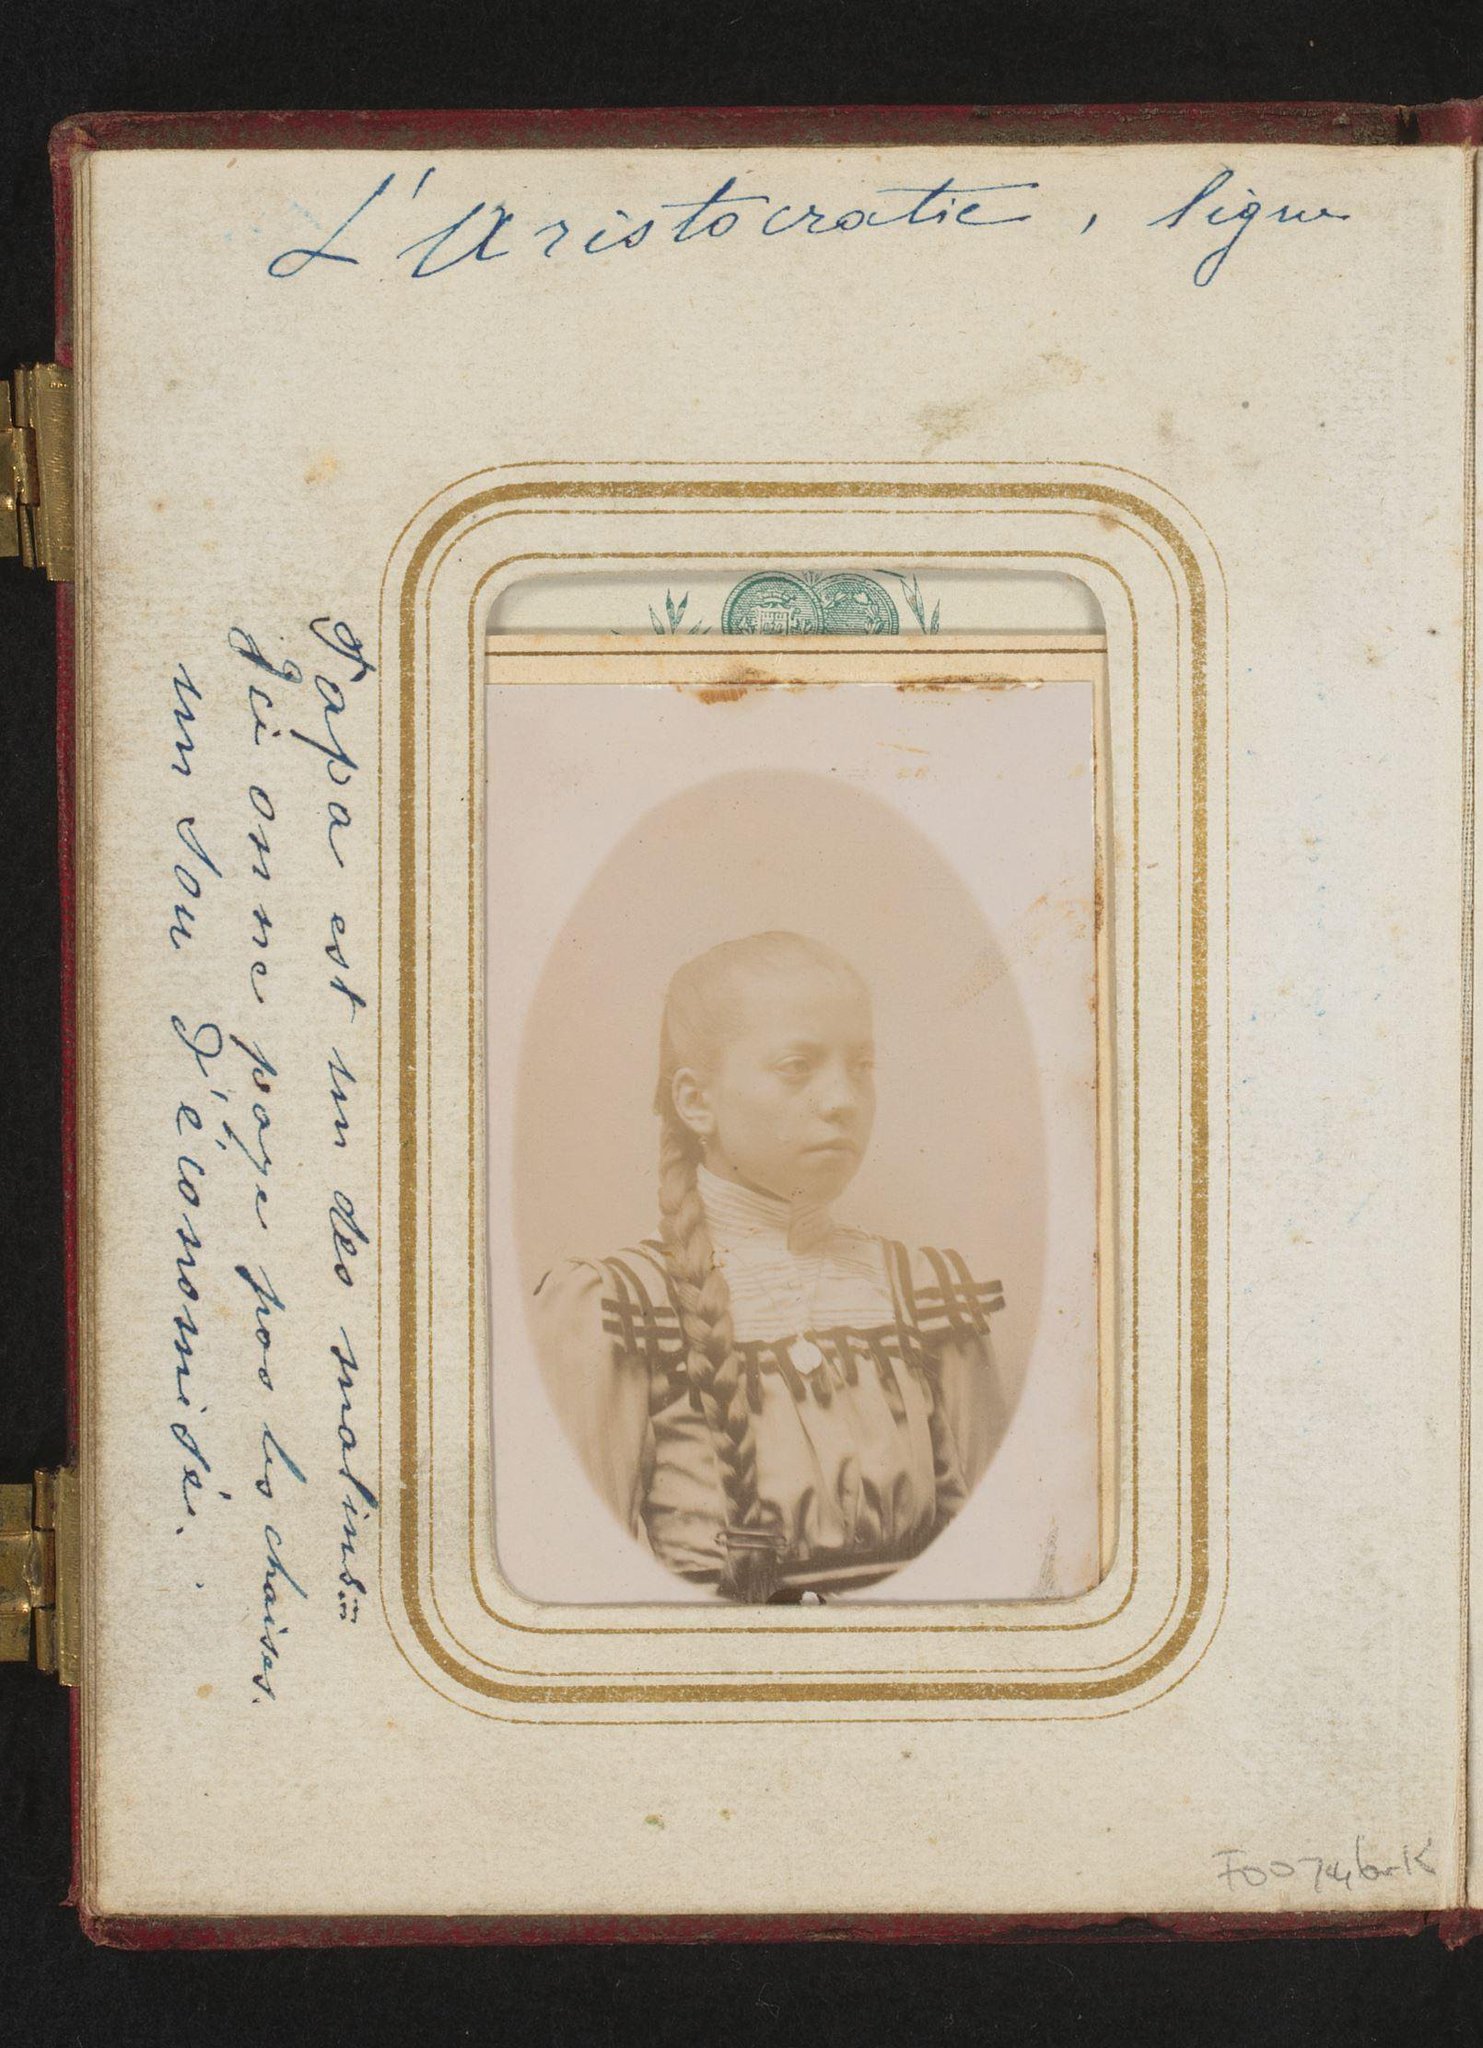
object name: album leaf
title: Portret van een meisje met een vlecht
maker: Anonymous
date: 1890-1910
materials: cardboard, photographic support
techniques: collodion silver print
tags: styles of hairdress (with name) - aa - ~ women, historical persons, girl (child between toddler and youth)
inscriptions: annotation: ‘L'Aristocratie ligne progressive descendante’, annotation: ‘Papa est unes des malins. Ici on ne paye pas les chaises. Un jou d'économise.’